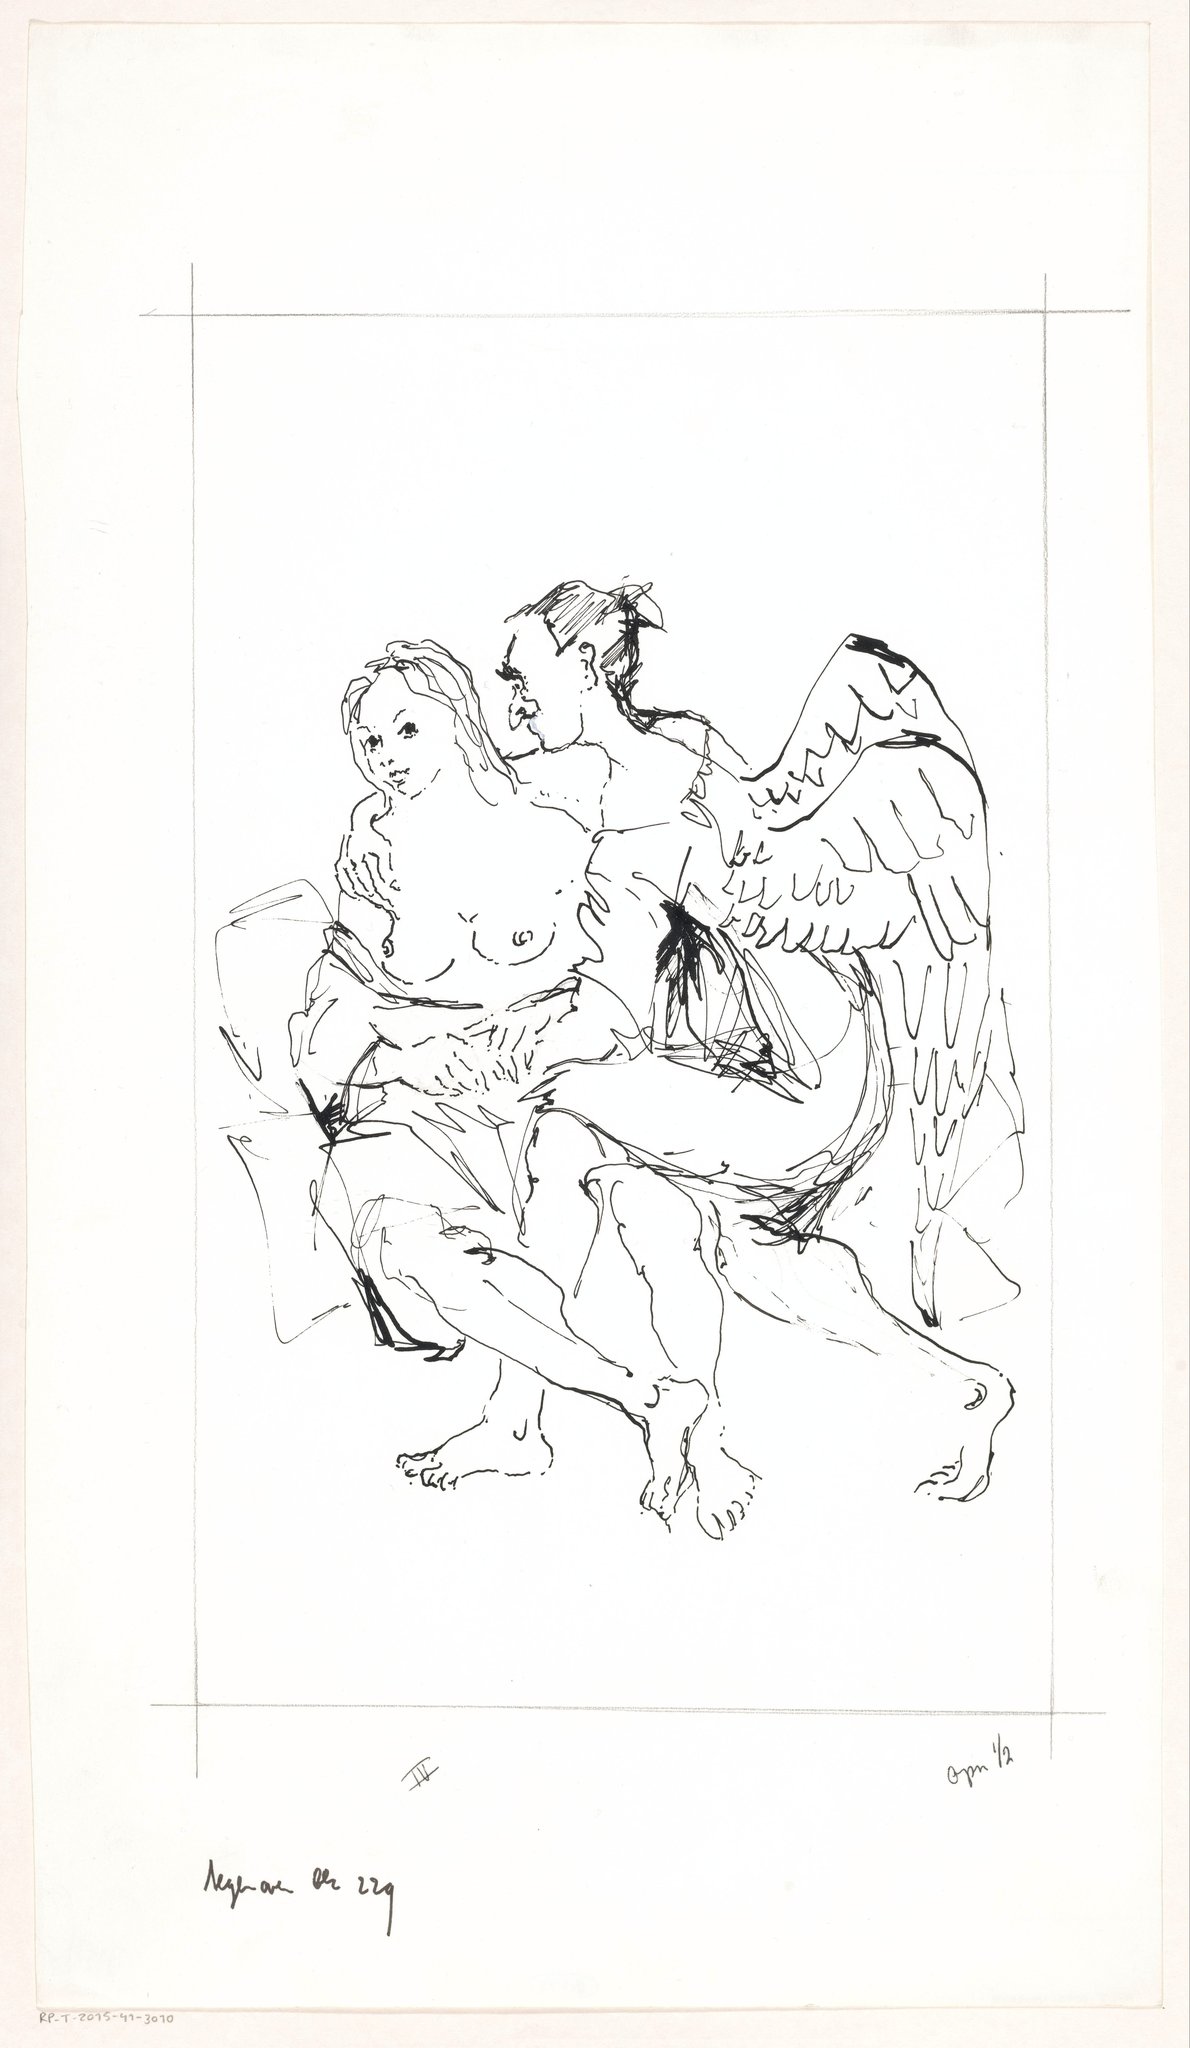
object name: drawing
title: Gevleugelde man omhelst een naakte vrouw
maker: Anonymous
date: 1900-1970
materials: paint, ink, paper, pencil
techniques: brush, pen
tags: (lovers) embracing each other, 'symplegma', woman (showing herself) undressed, quasi-nude, angels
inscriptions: :, annotation: ‘IV/ tegen over blz 229’, collector's mark: Lugt 2228a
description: Een mannelijke engel met een haakneus vleit zich naast een naakte, zittende vrouw en legt zijn arm over haar schouder.